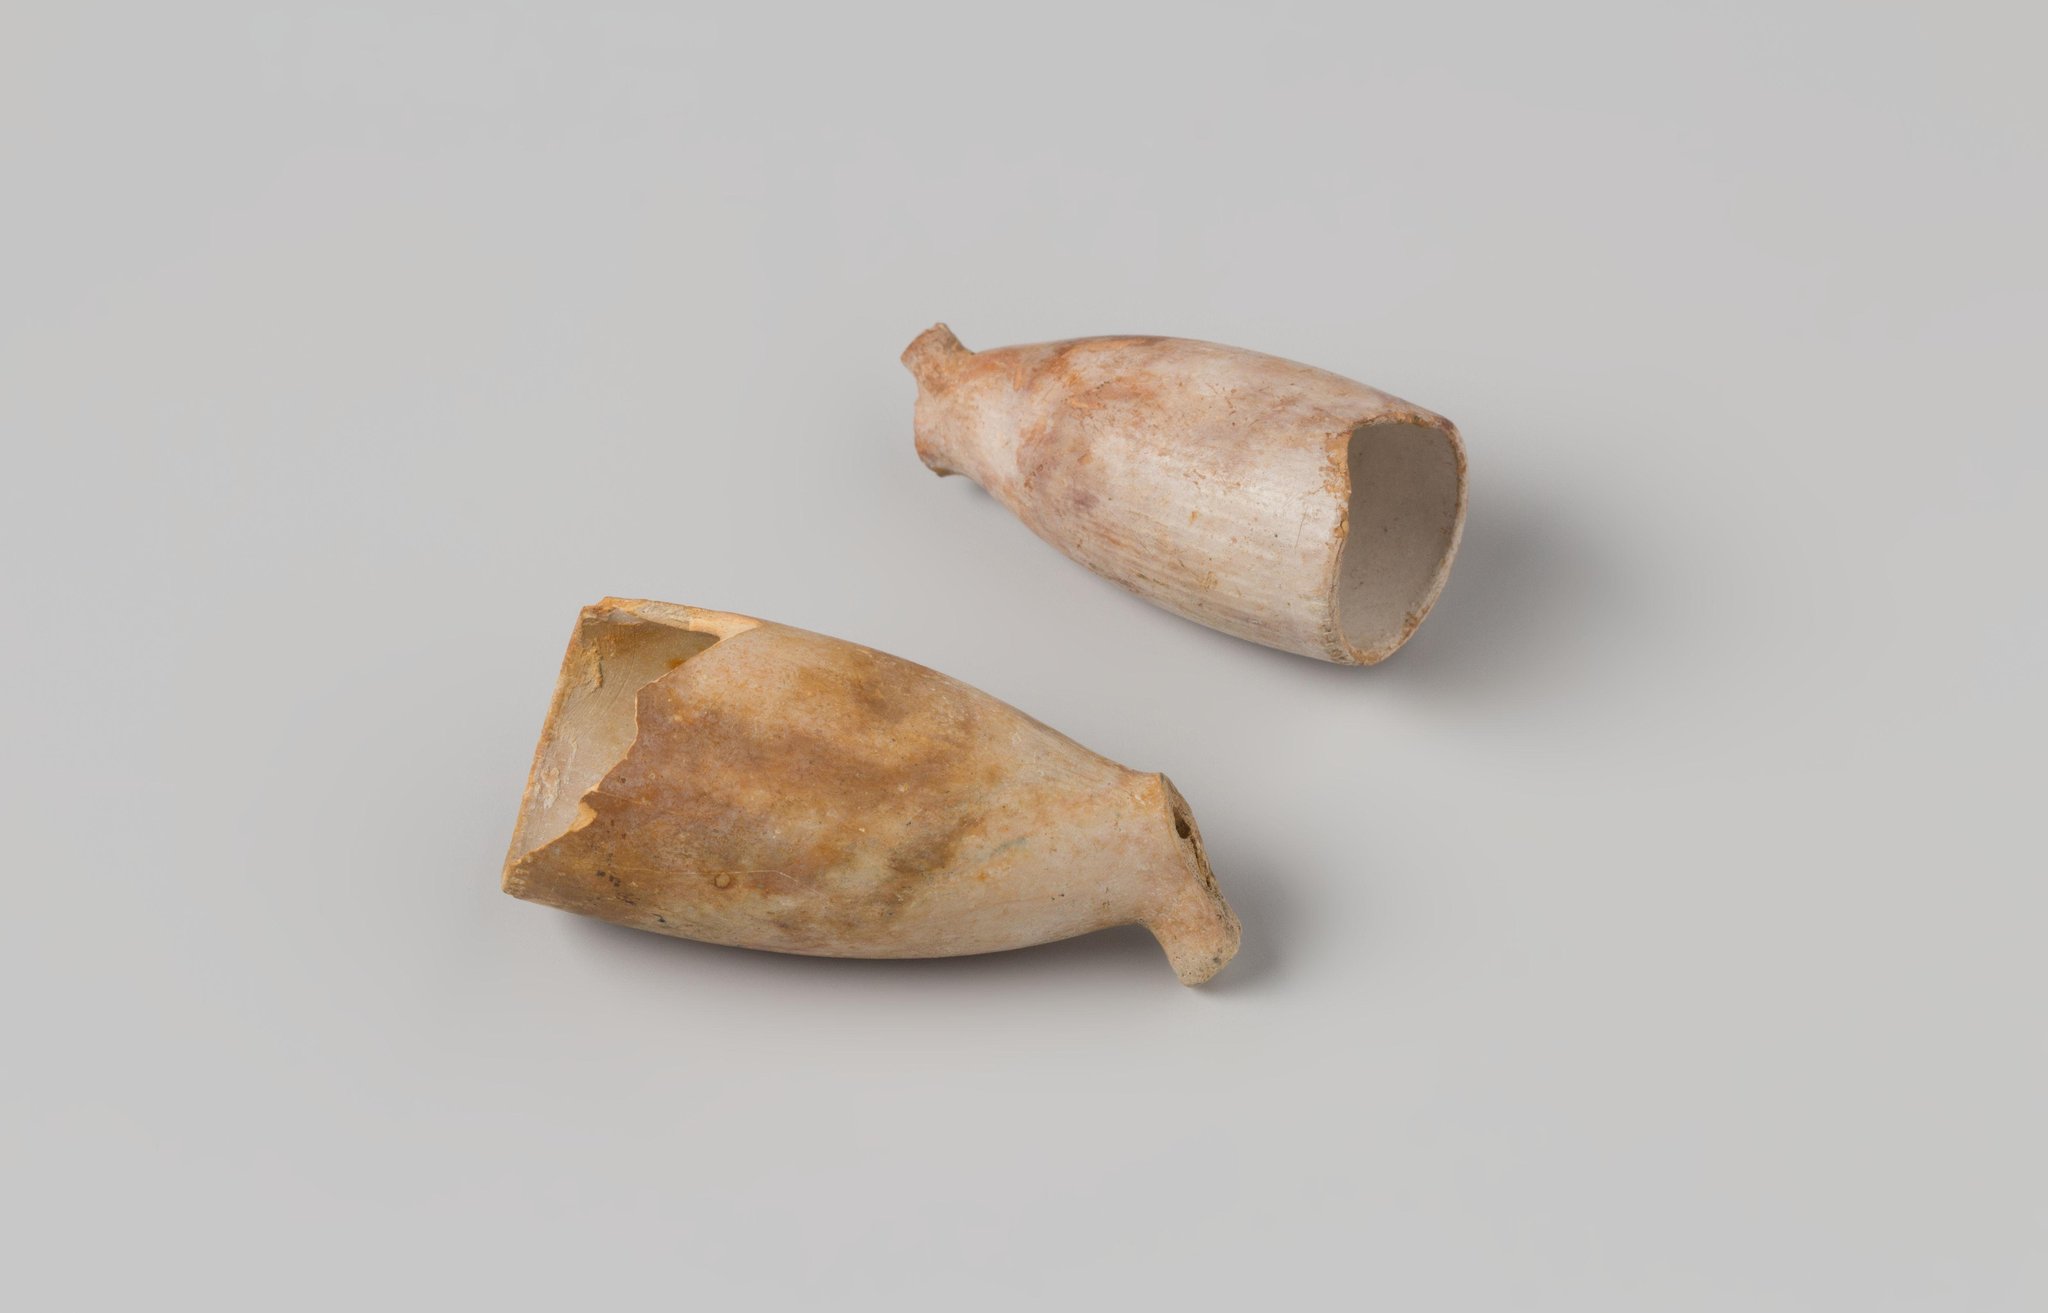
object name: pipe bowl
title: Pijpenkoppen uit het wrak van de Oost-Indiëvaarder Hollandia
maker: Anonymous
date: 1700-1743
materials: clay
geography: netherlands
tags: verenigde oostindische compagnie, hollandia (schip), annet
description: Pipe, bowl, heelmark: crowned 91; 1hsm1.